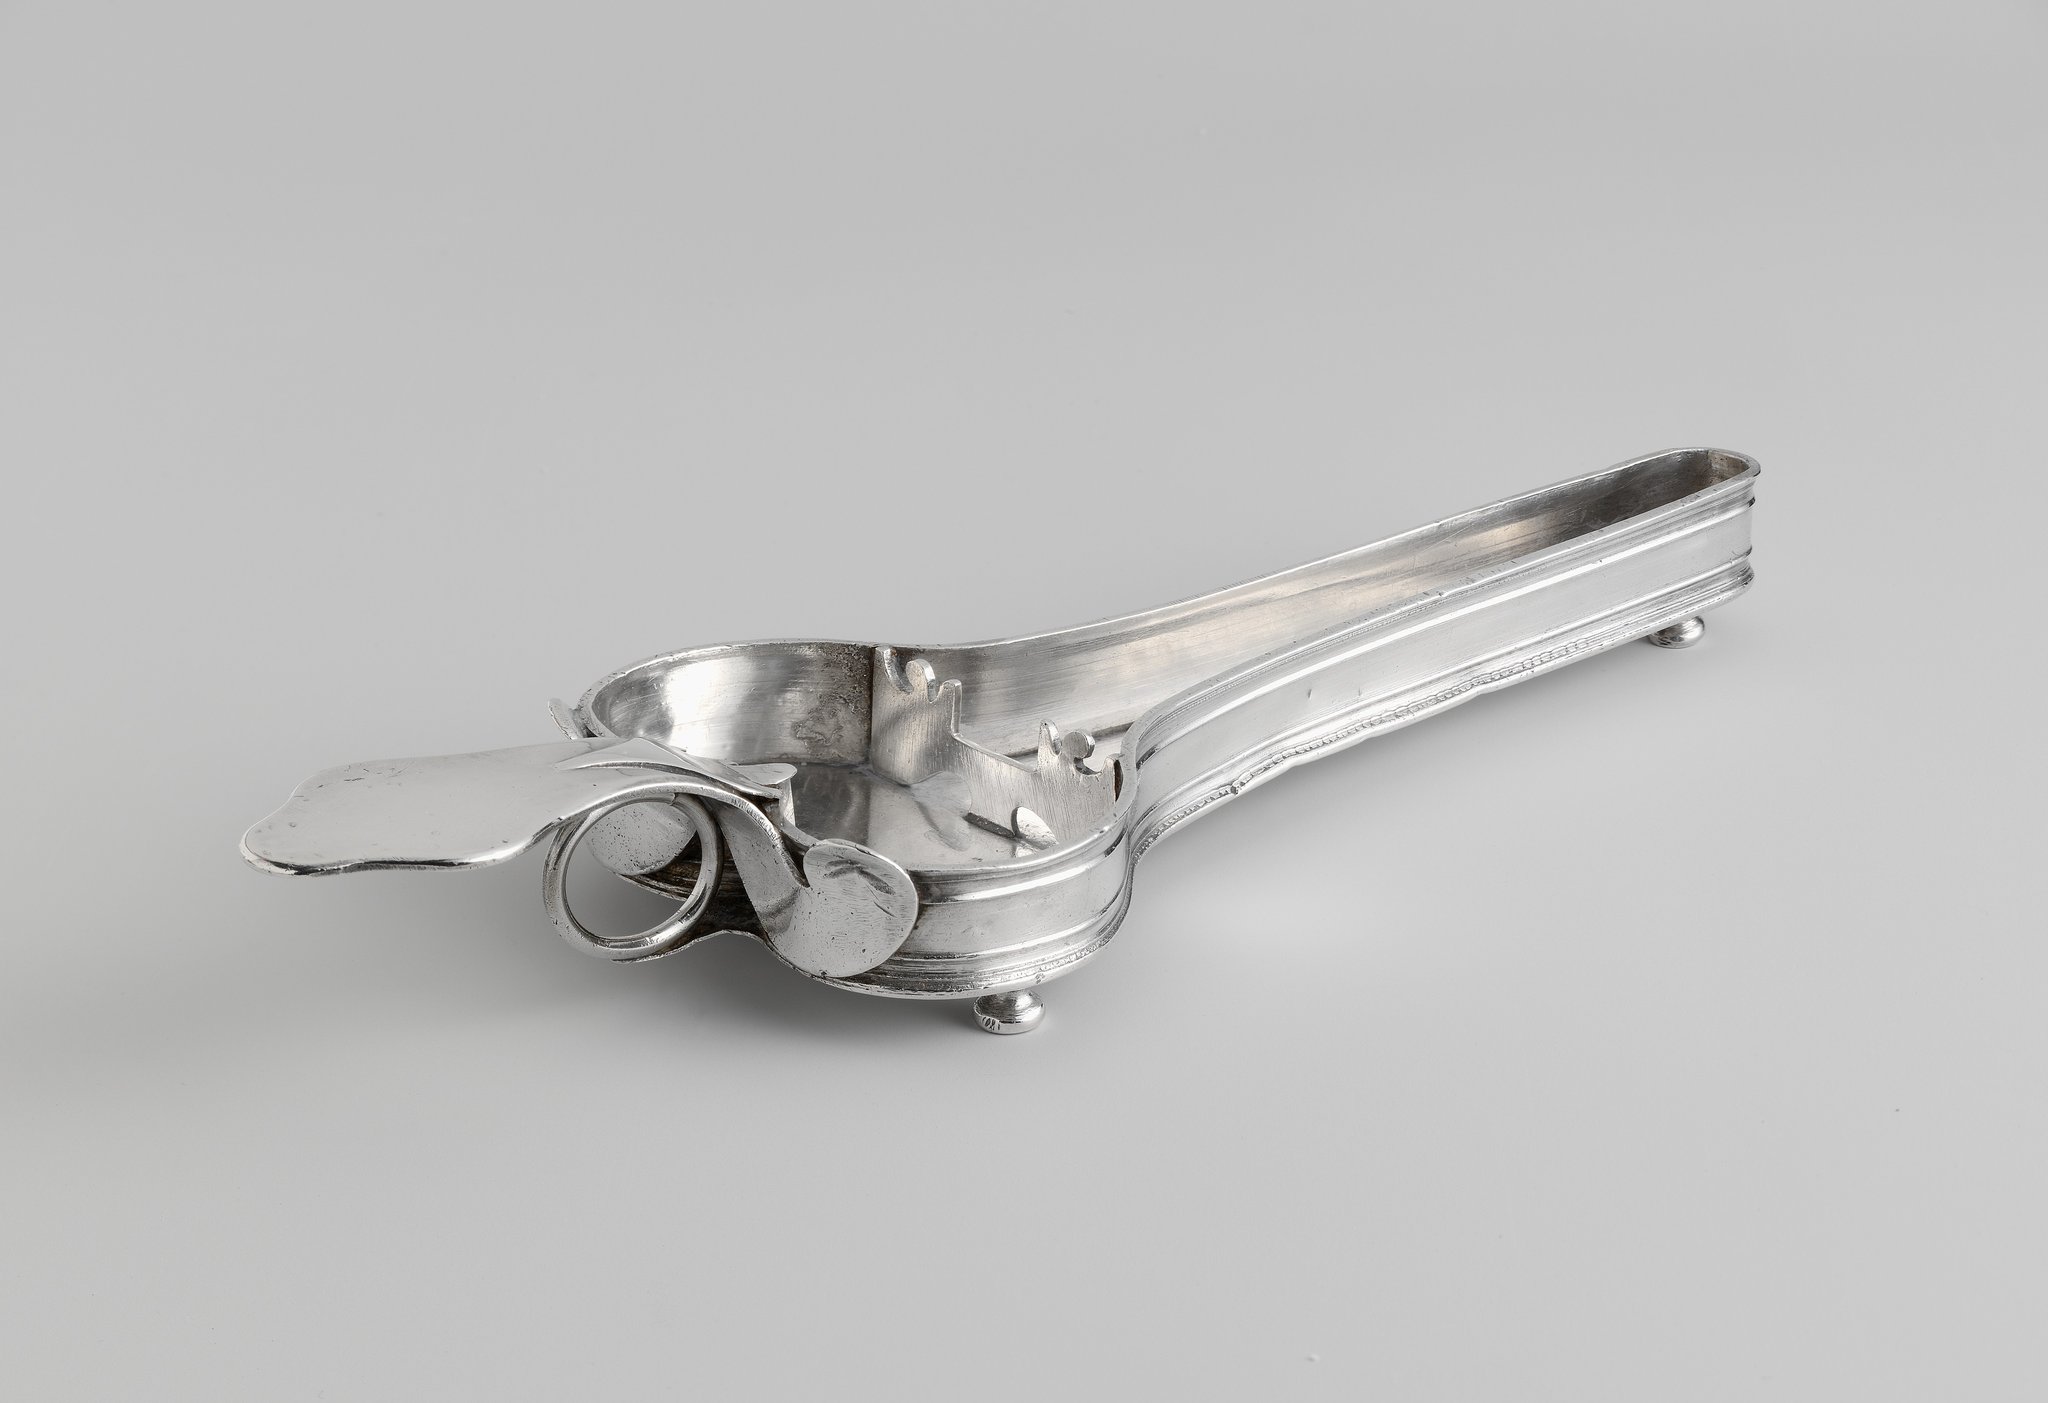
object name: tray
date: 1681-1684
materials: silver